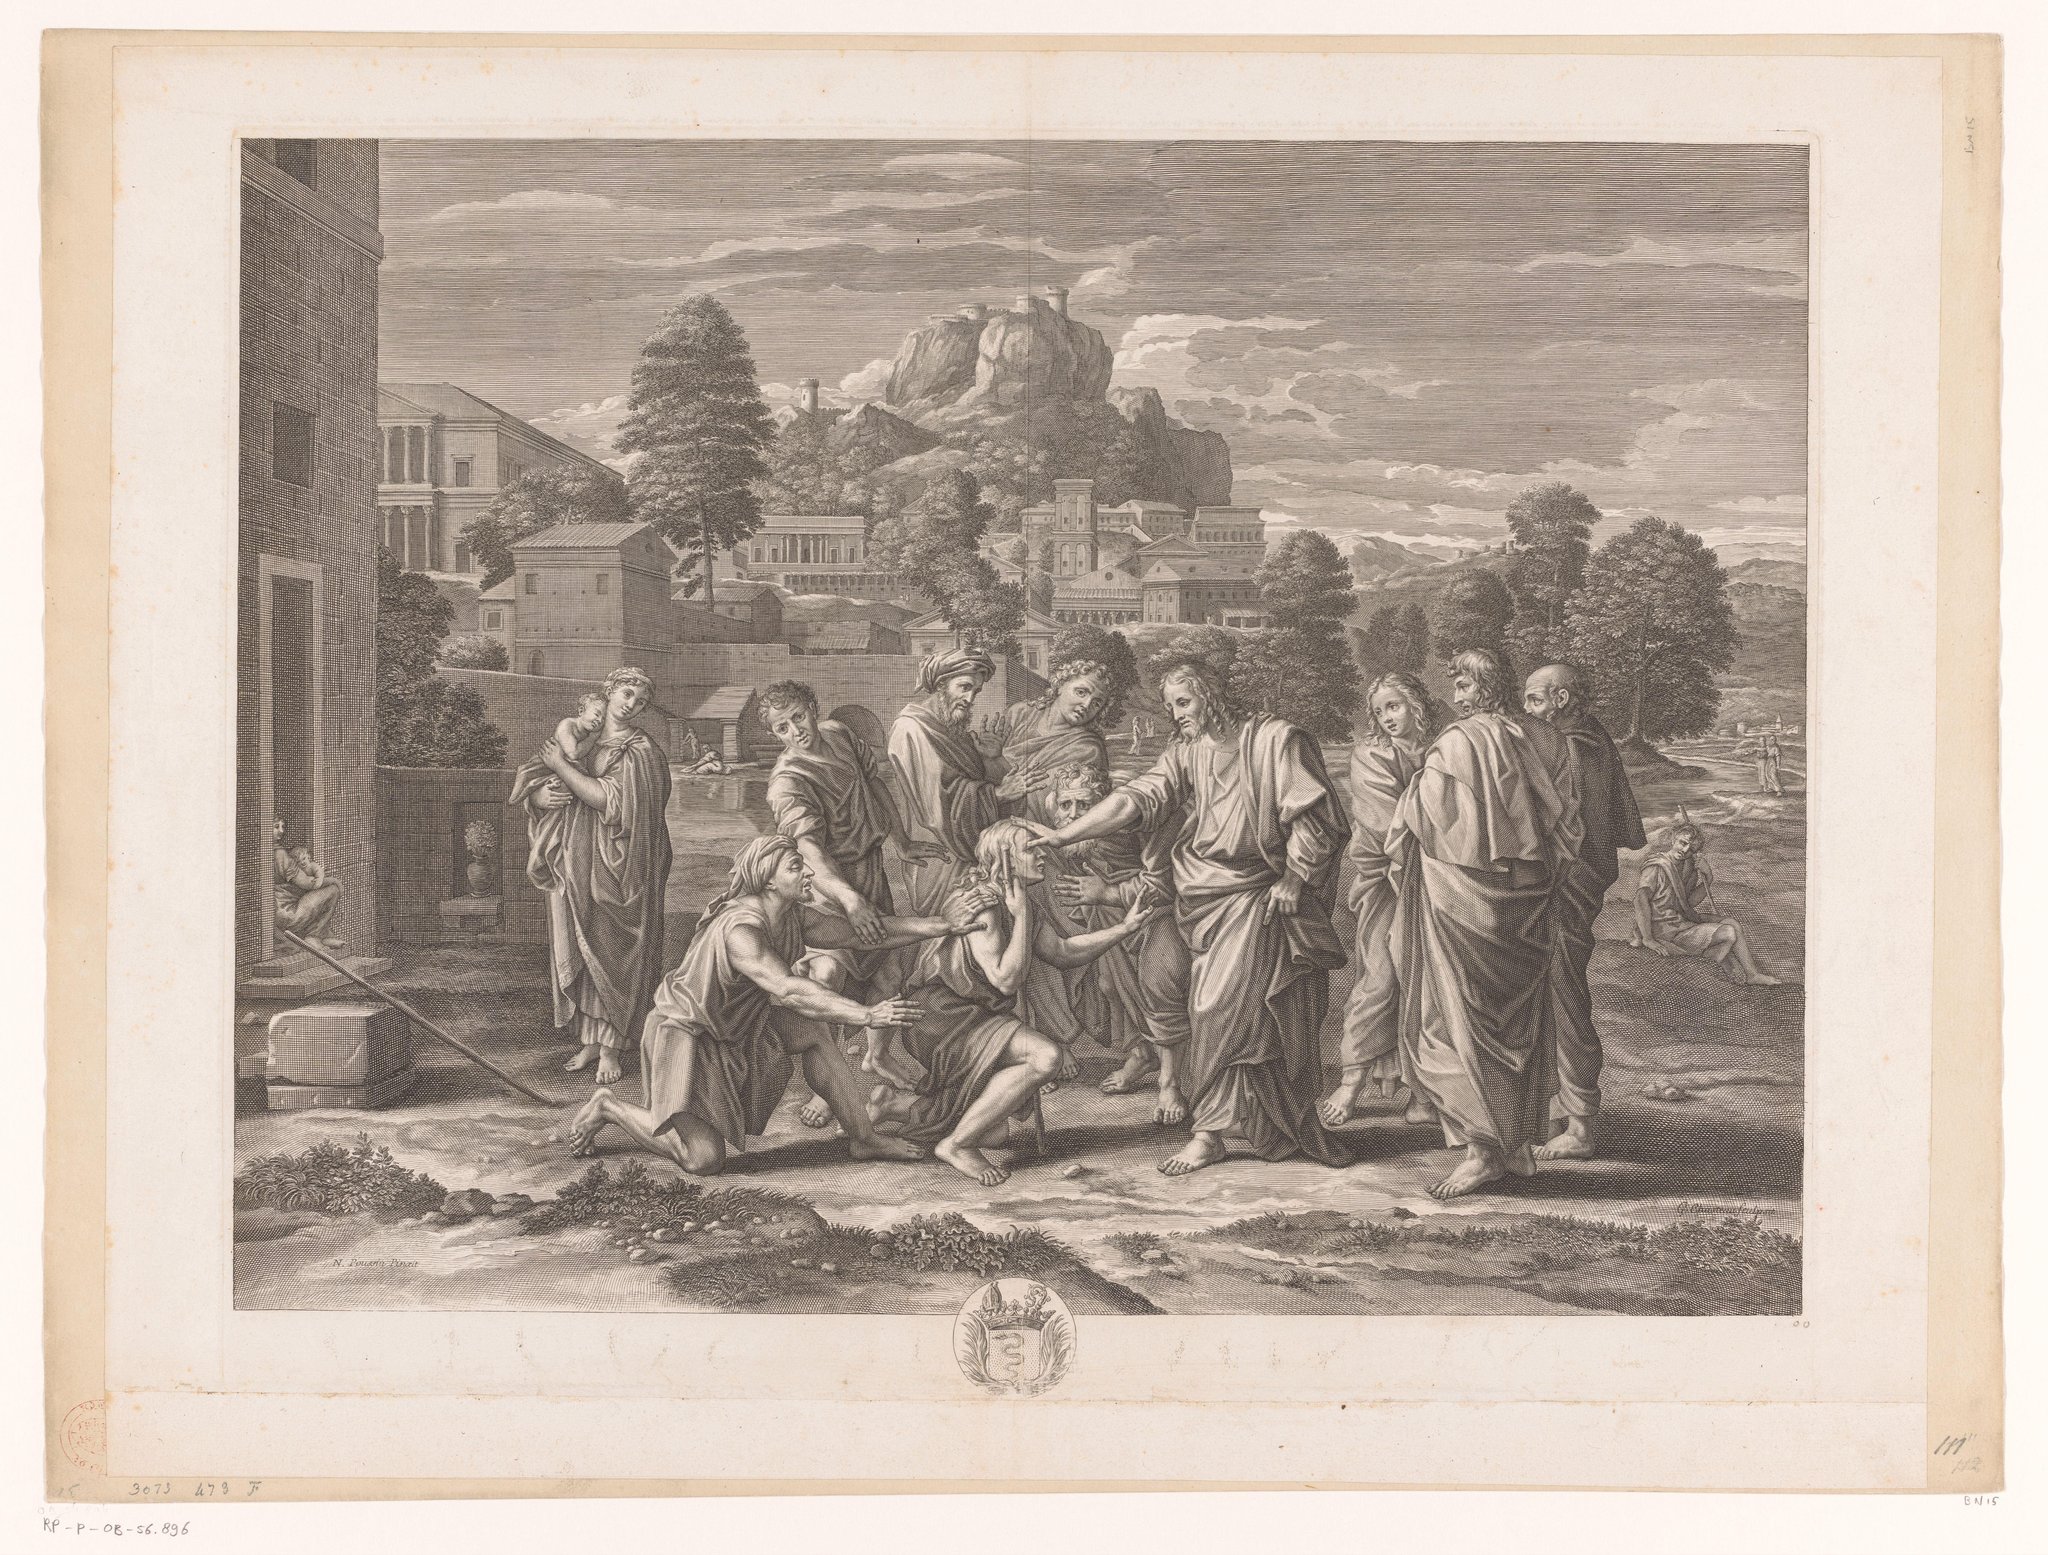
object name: print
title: Christus geneest twee blinden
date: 1672-1674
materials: paper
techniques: engraving, etching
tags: healing of two blind men, or one (bartimaeus), sitting near jericho (matthew 20:29-34; mark 10:46-52; luke 18:35-43)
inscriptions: watermark, collector's mark: Lugt 240, number: ‘93’